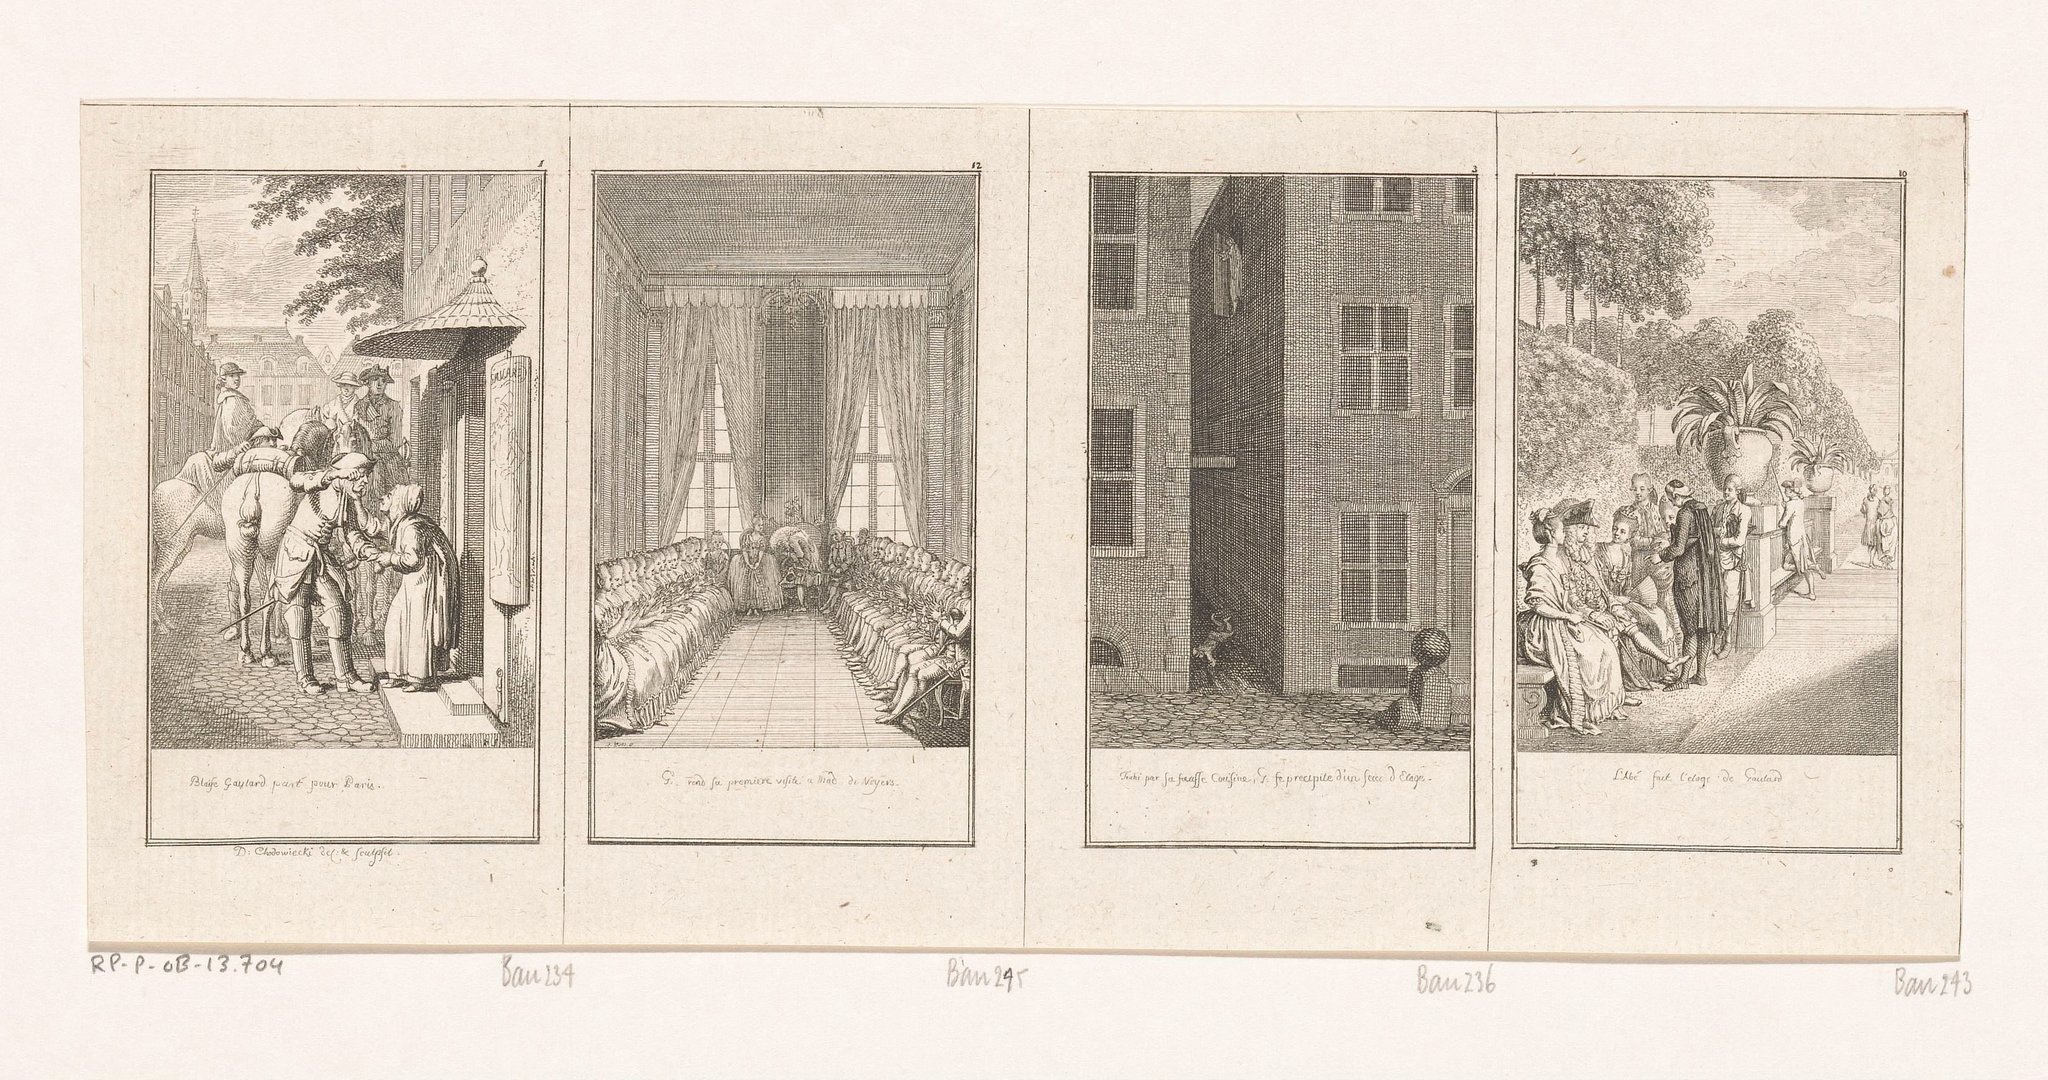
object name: print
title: Vier scènes uit de geschiedenis van Blaise Gaulard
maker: daniel nikolaus chodowiecki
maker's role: draughtsman, print maker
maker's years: 1726-1801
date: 1775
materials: paper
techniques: etching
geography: berlin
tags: literature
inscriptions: collector's mark: Lugt 240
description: Links vertrekt Blaise Gaulard van huis. Daarnaast een zaal met mannen en vrouwen die applaudisseren voor Blaise Gaulard en Mme. des Noyers. Daarnaast ligt Blaise Gaulard in een steeg nadat hij door een deur naar beneden gevallen is. Rechts Blaise Gaulard omringd door vrouwen in de Jardin du Luxembourg. Genummerd: 1, 12, 3 en 10.